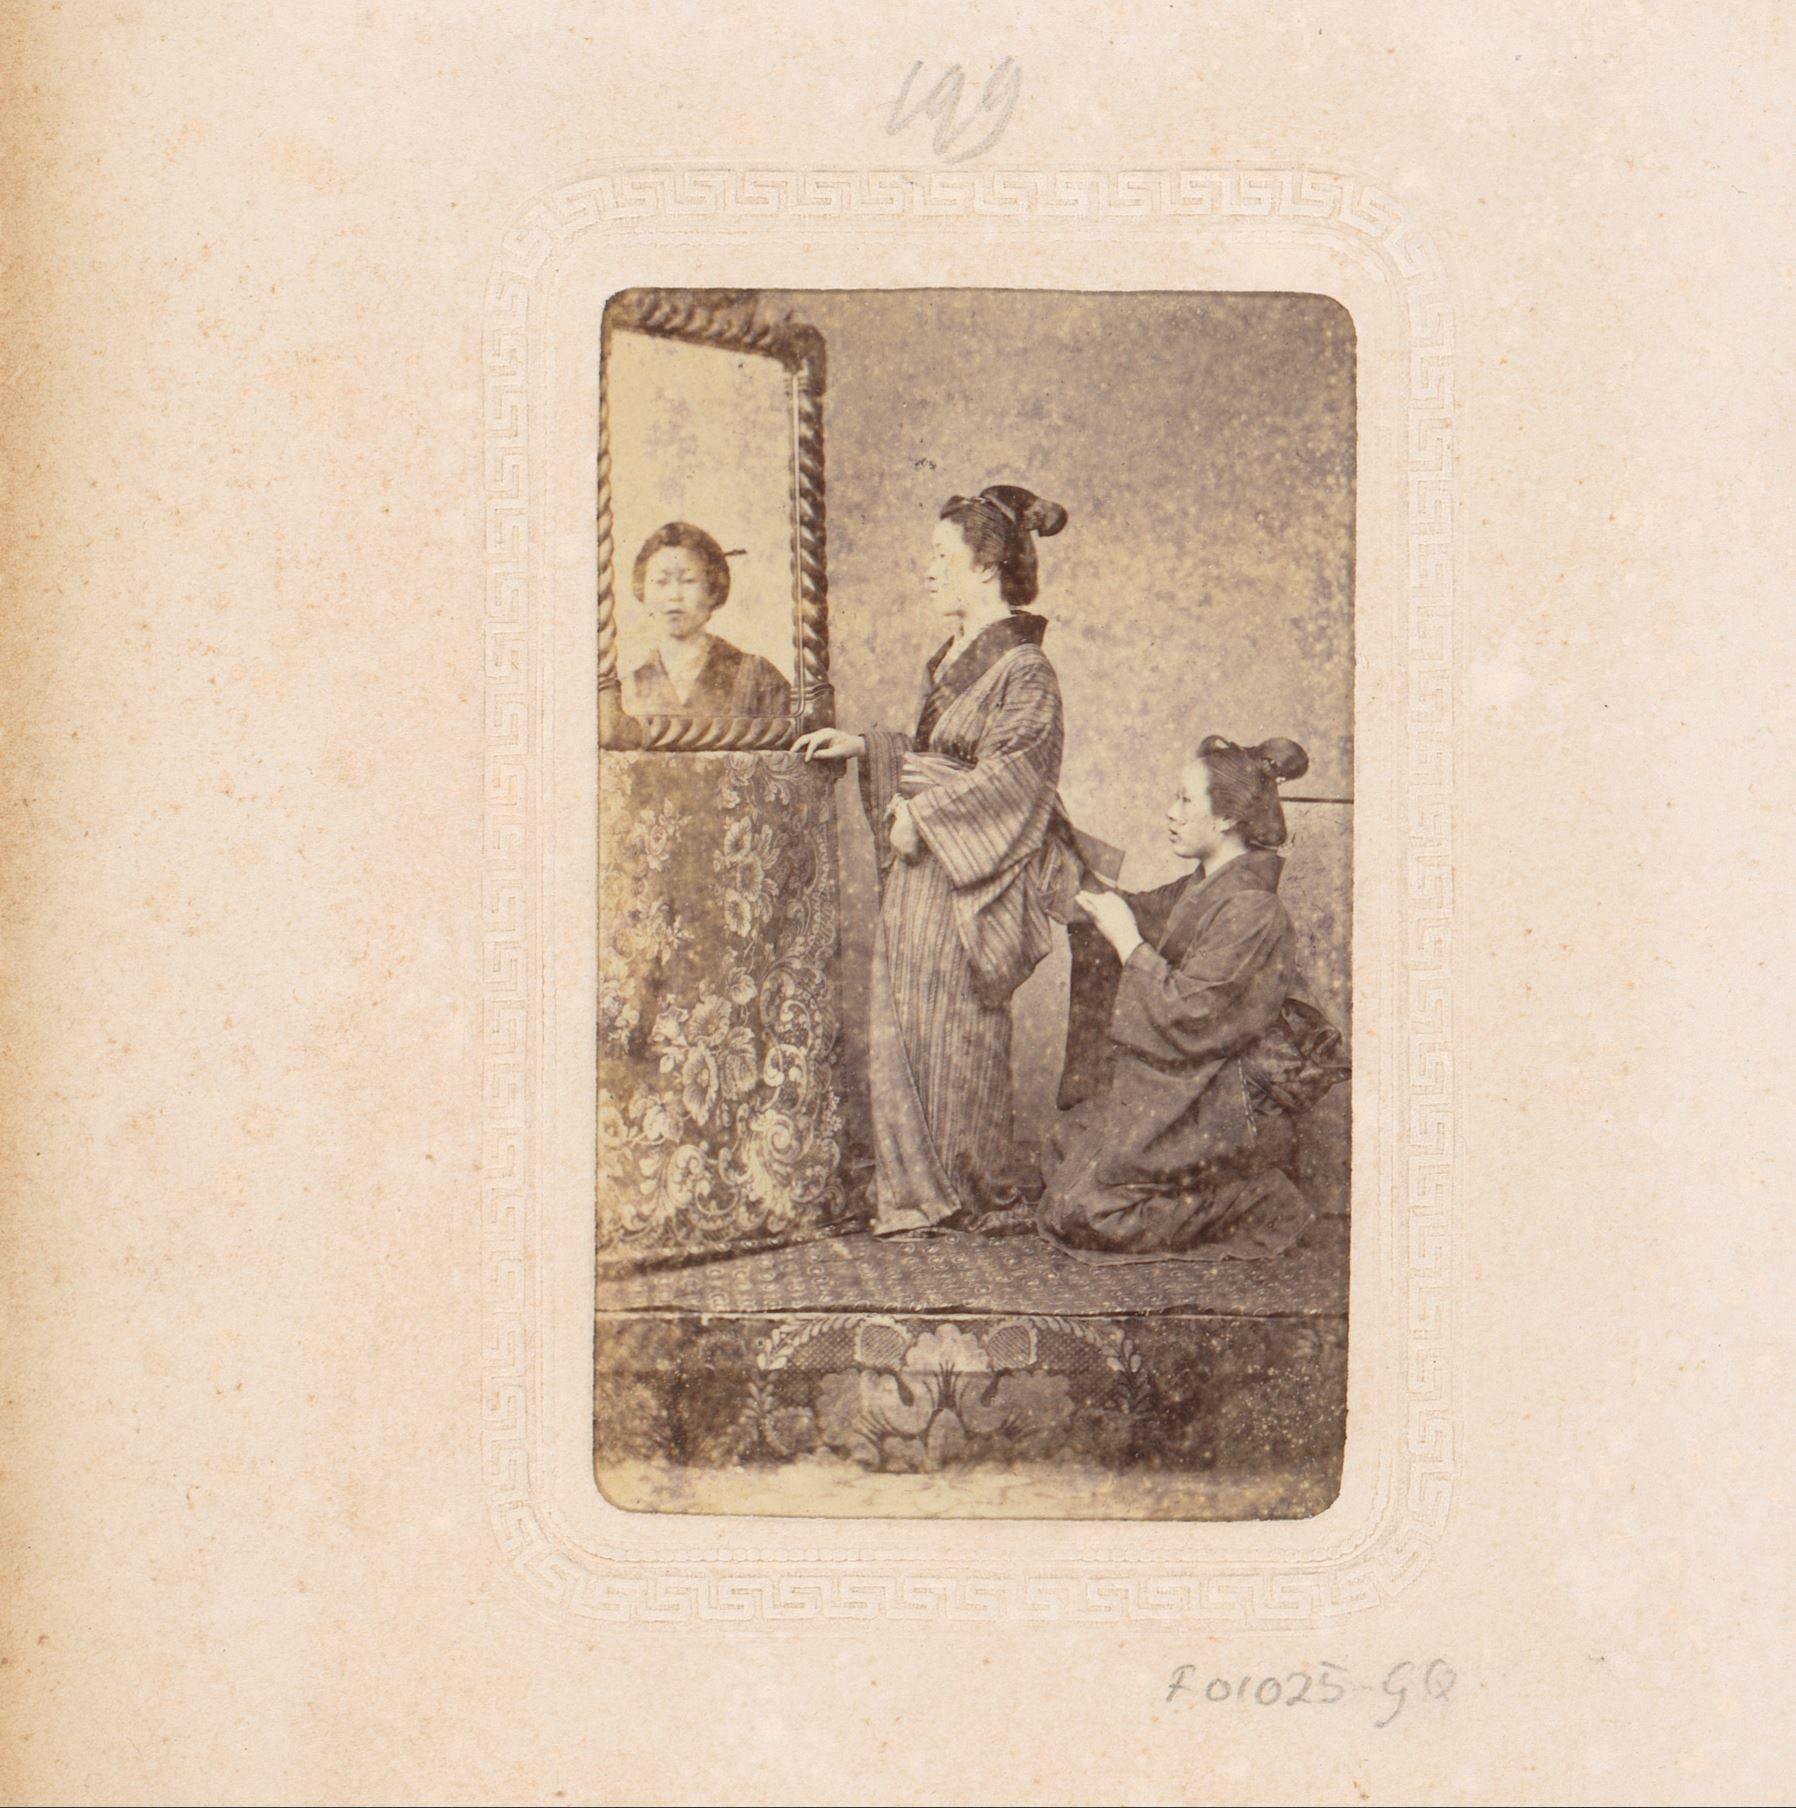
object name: photograph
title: Portret van Japanse vrouwen voor de spiegel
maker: Anonymous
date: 1850-1880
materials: cardboard, photographic support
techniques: albumen print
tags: adult woman, historical persons - bb - woman, mirror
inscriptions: number: ‘199’